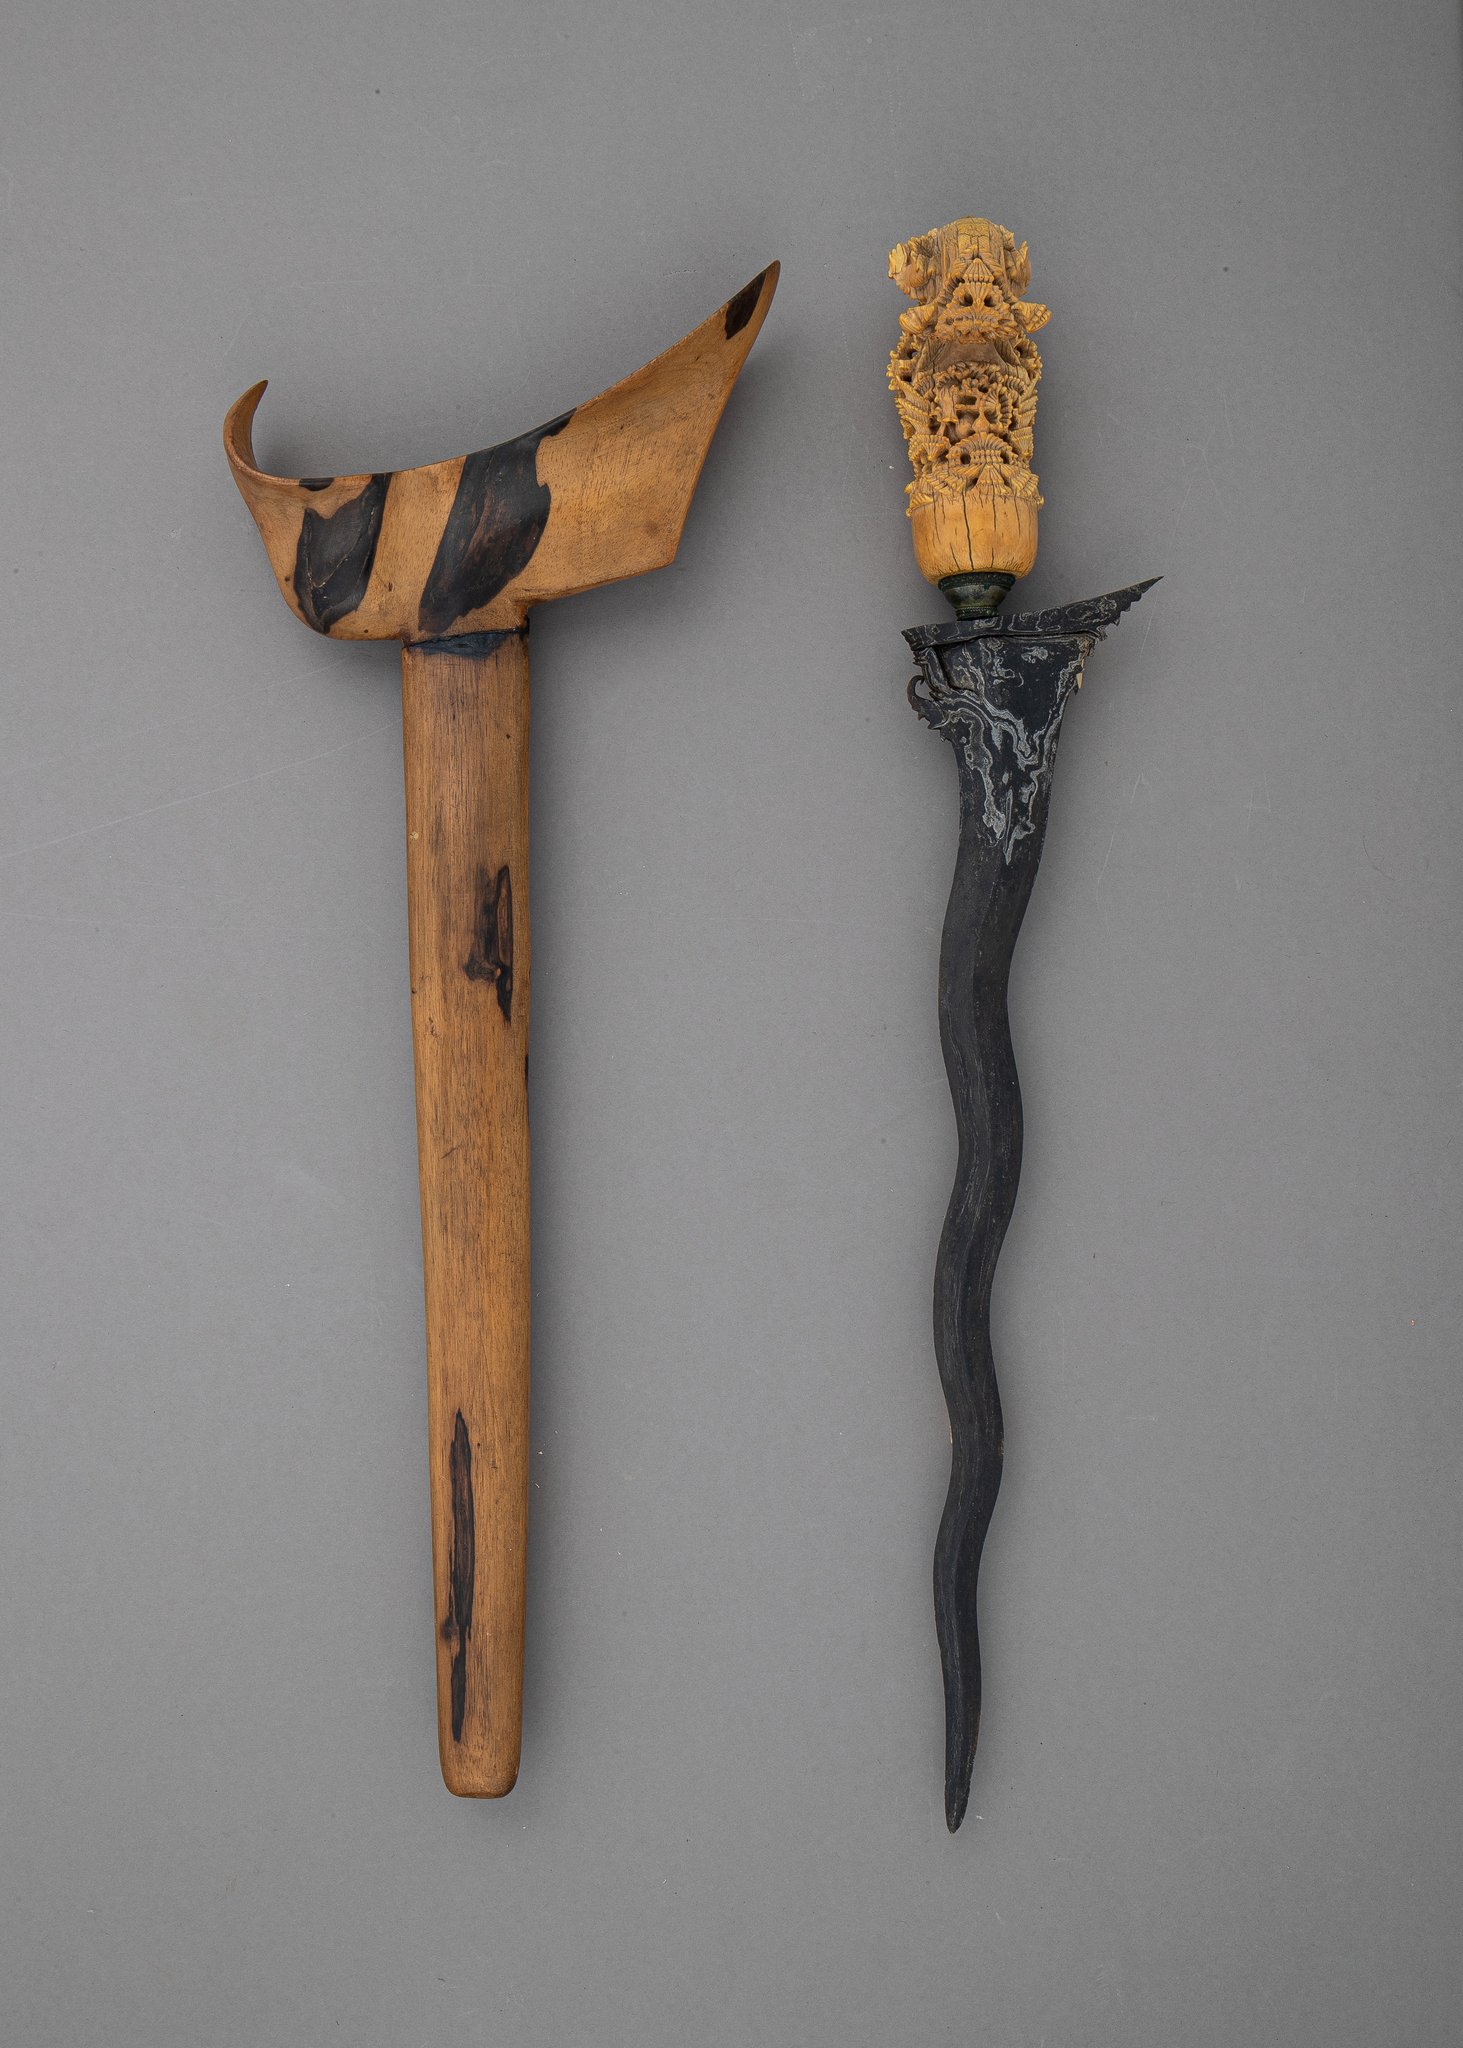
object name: kris with sheath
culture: madurese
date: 1701-1900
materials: ivory, silver, steel, wood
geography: indonesia